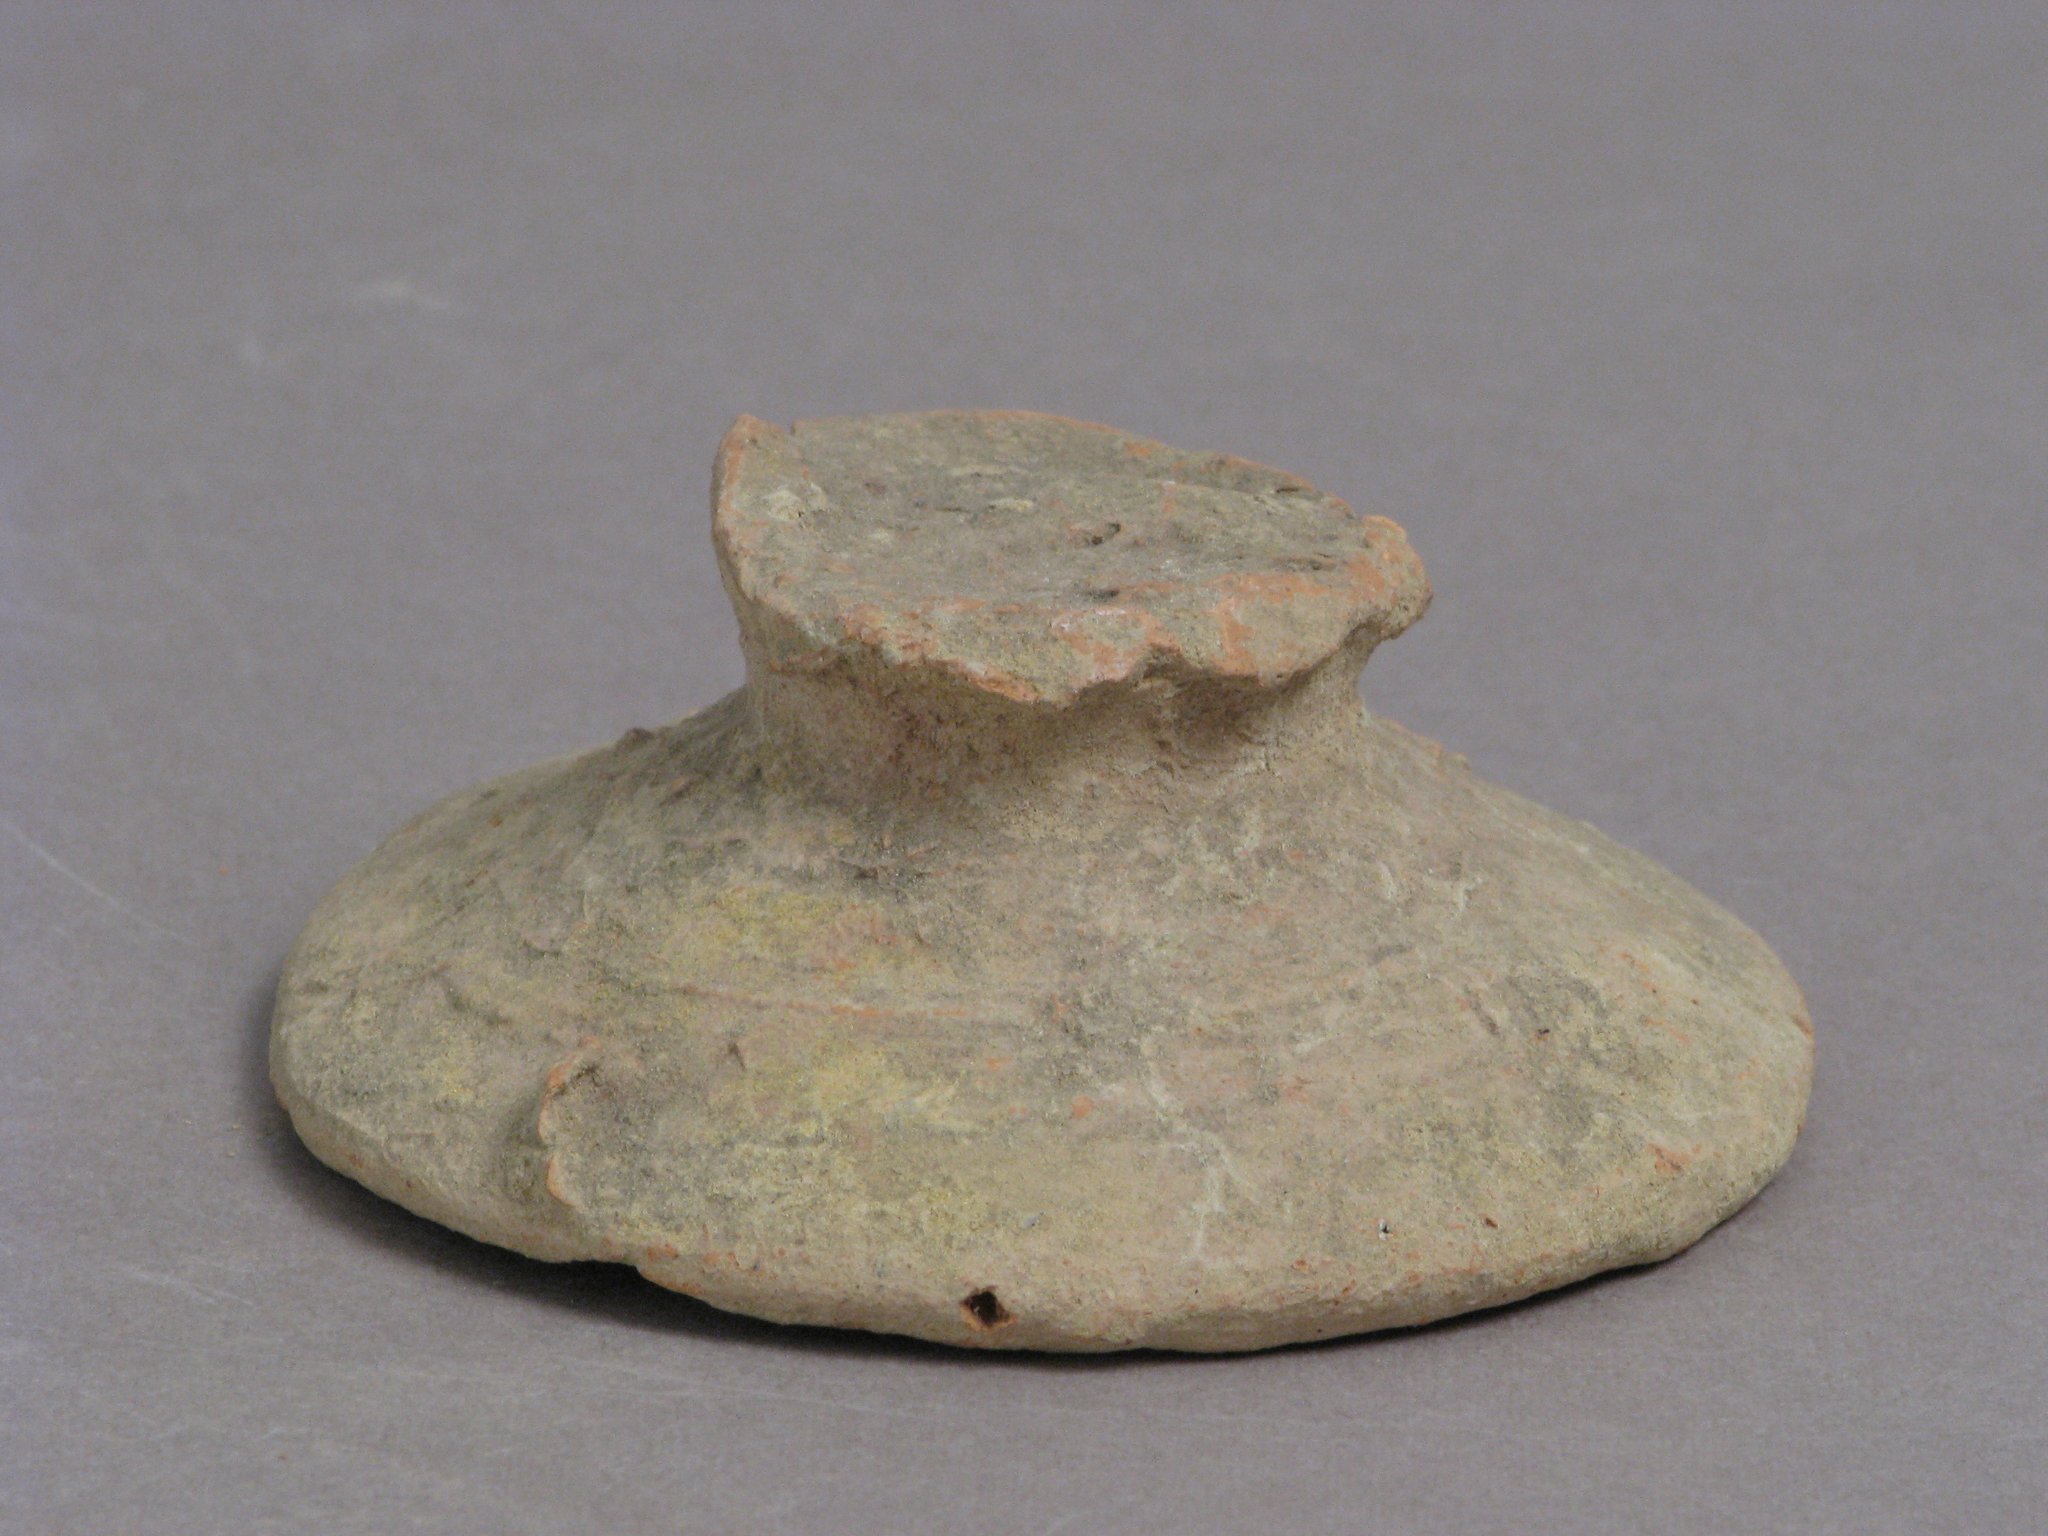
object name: lid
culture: coptic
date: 301-700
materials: earthenware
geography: egypt